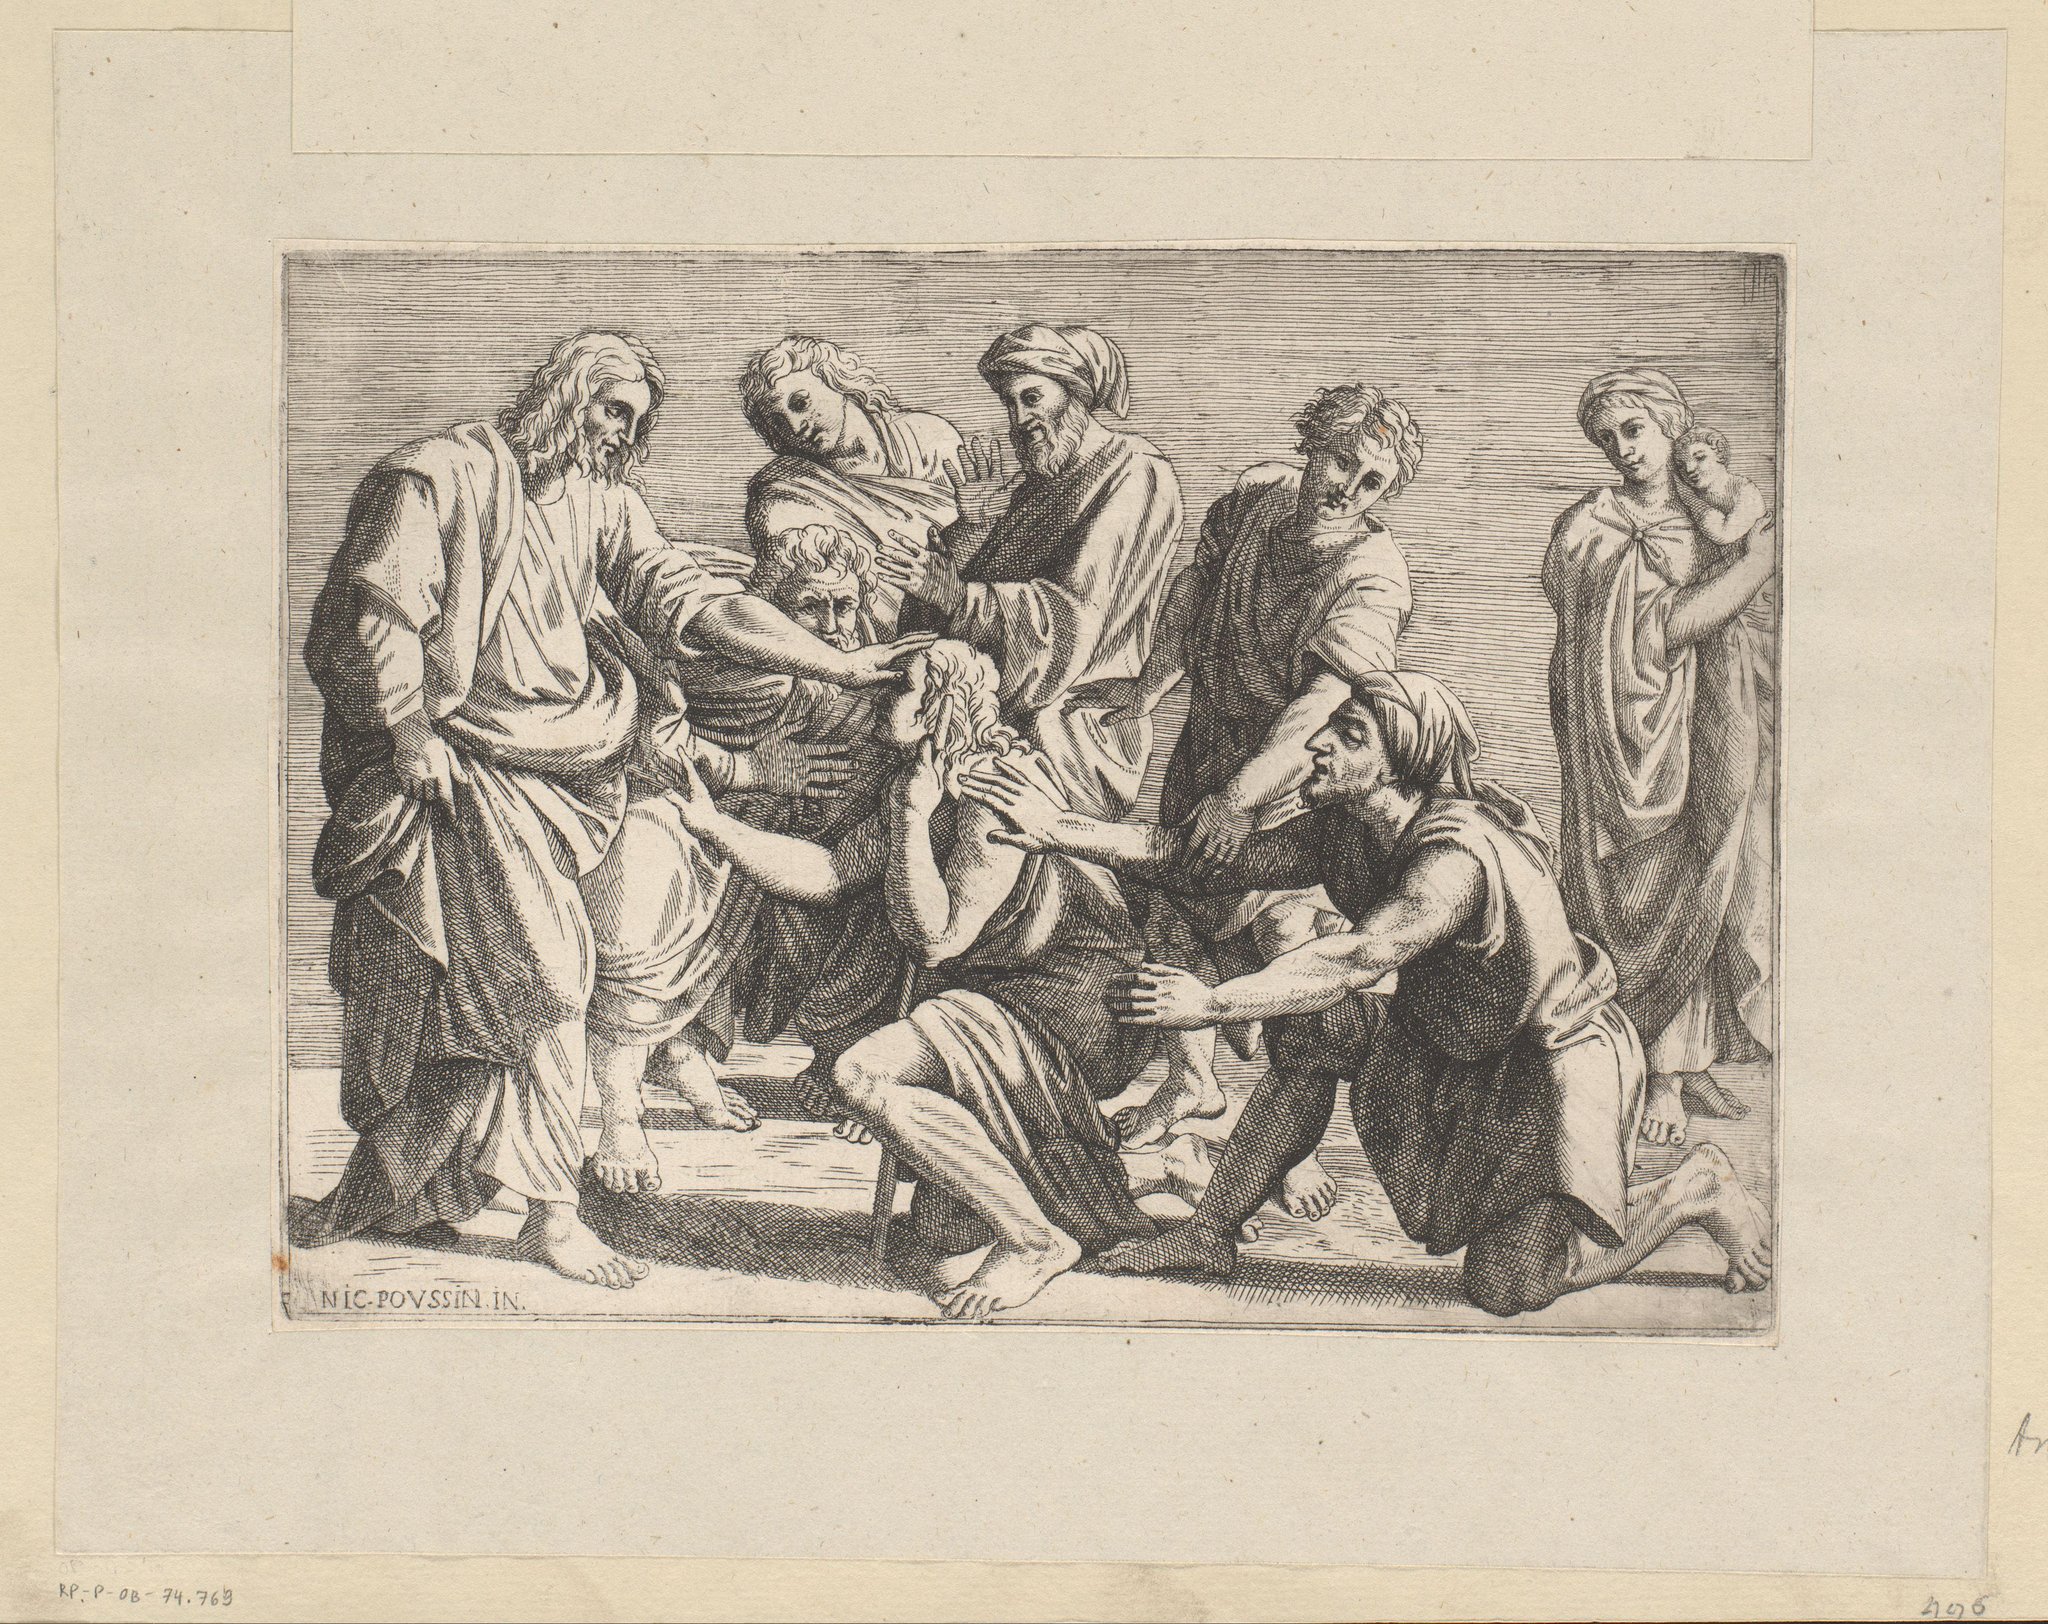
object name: print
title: Christus geneest de blinden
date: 1650-1700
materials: paper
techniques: engraving, etching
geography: france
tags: christ healing blind people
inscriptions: collector's mark: Lugt 240